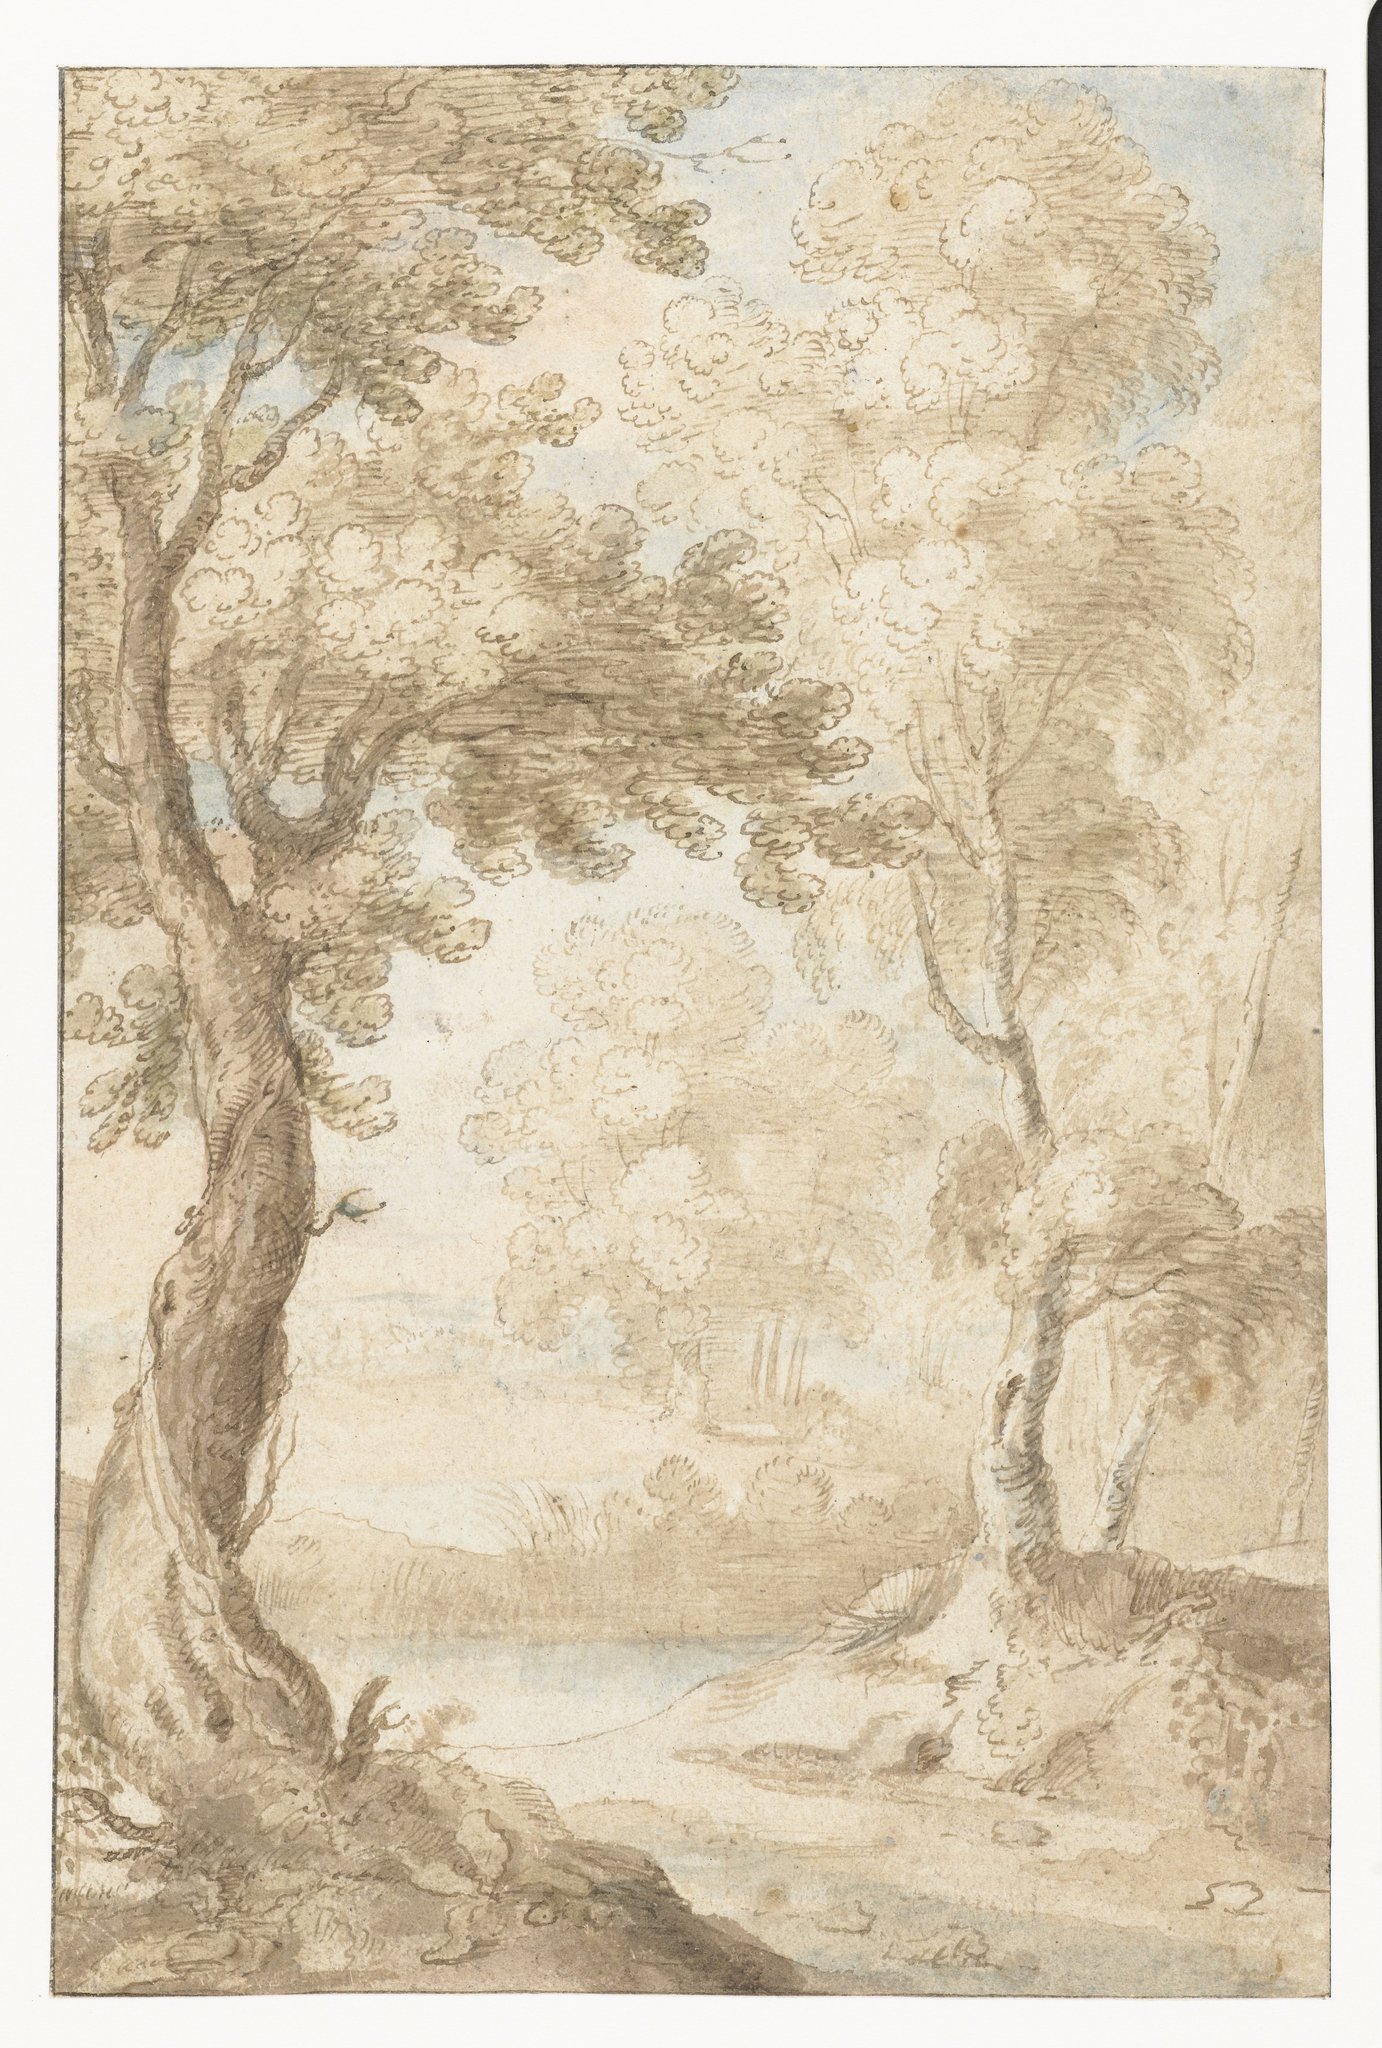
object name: drawing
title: Bosrijk landschap met water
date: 1600-1659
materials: paper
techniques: brush, pen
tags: forest, wood